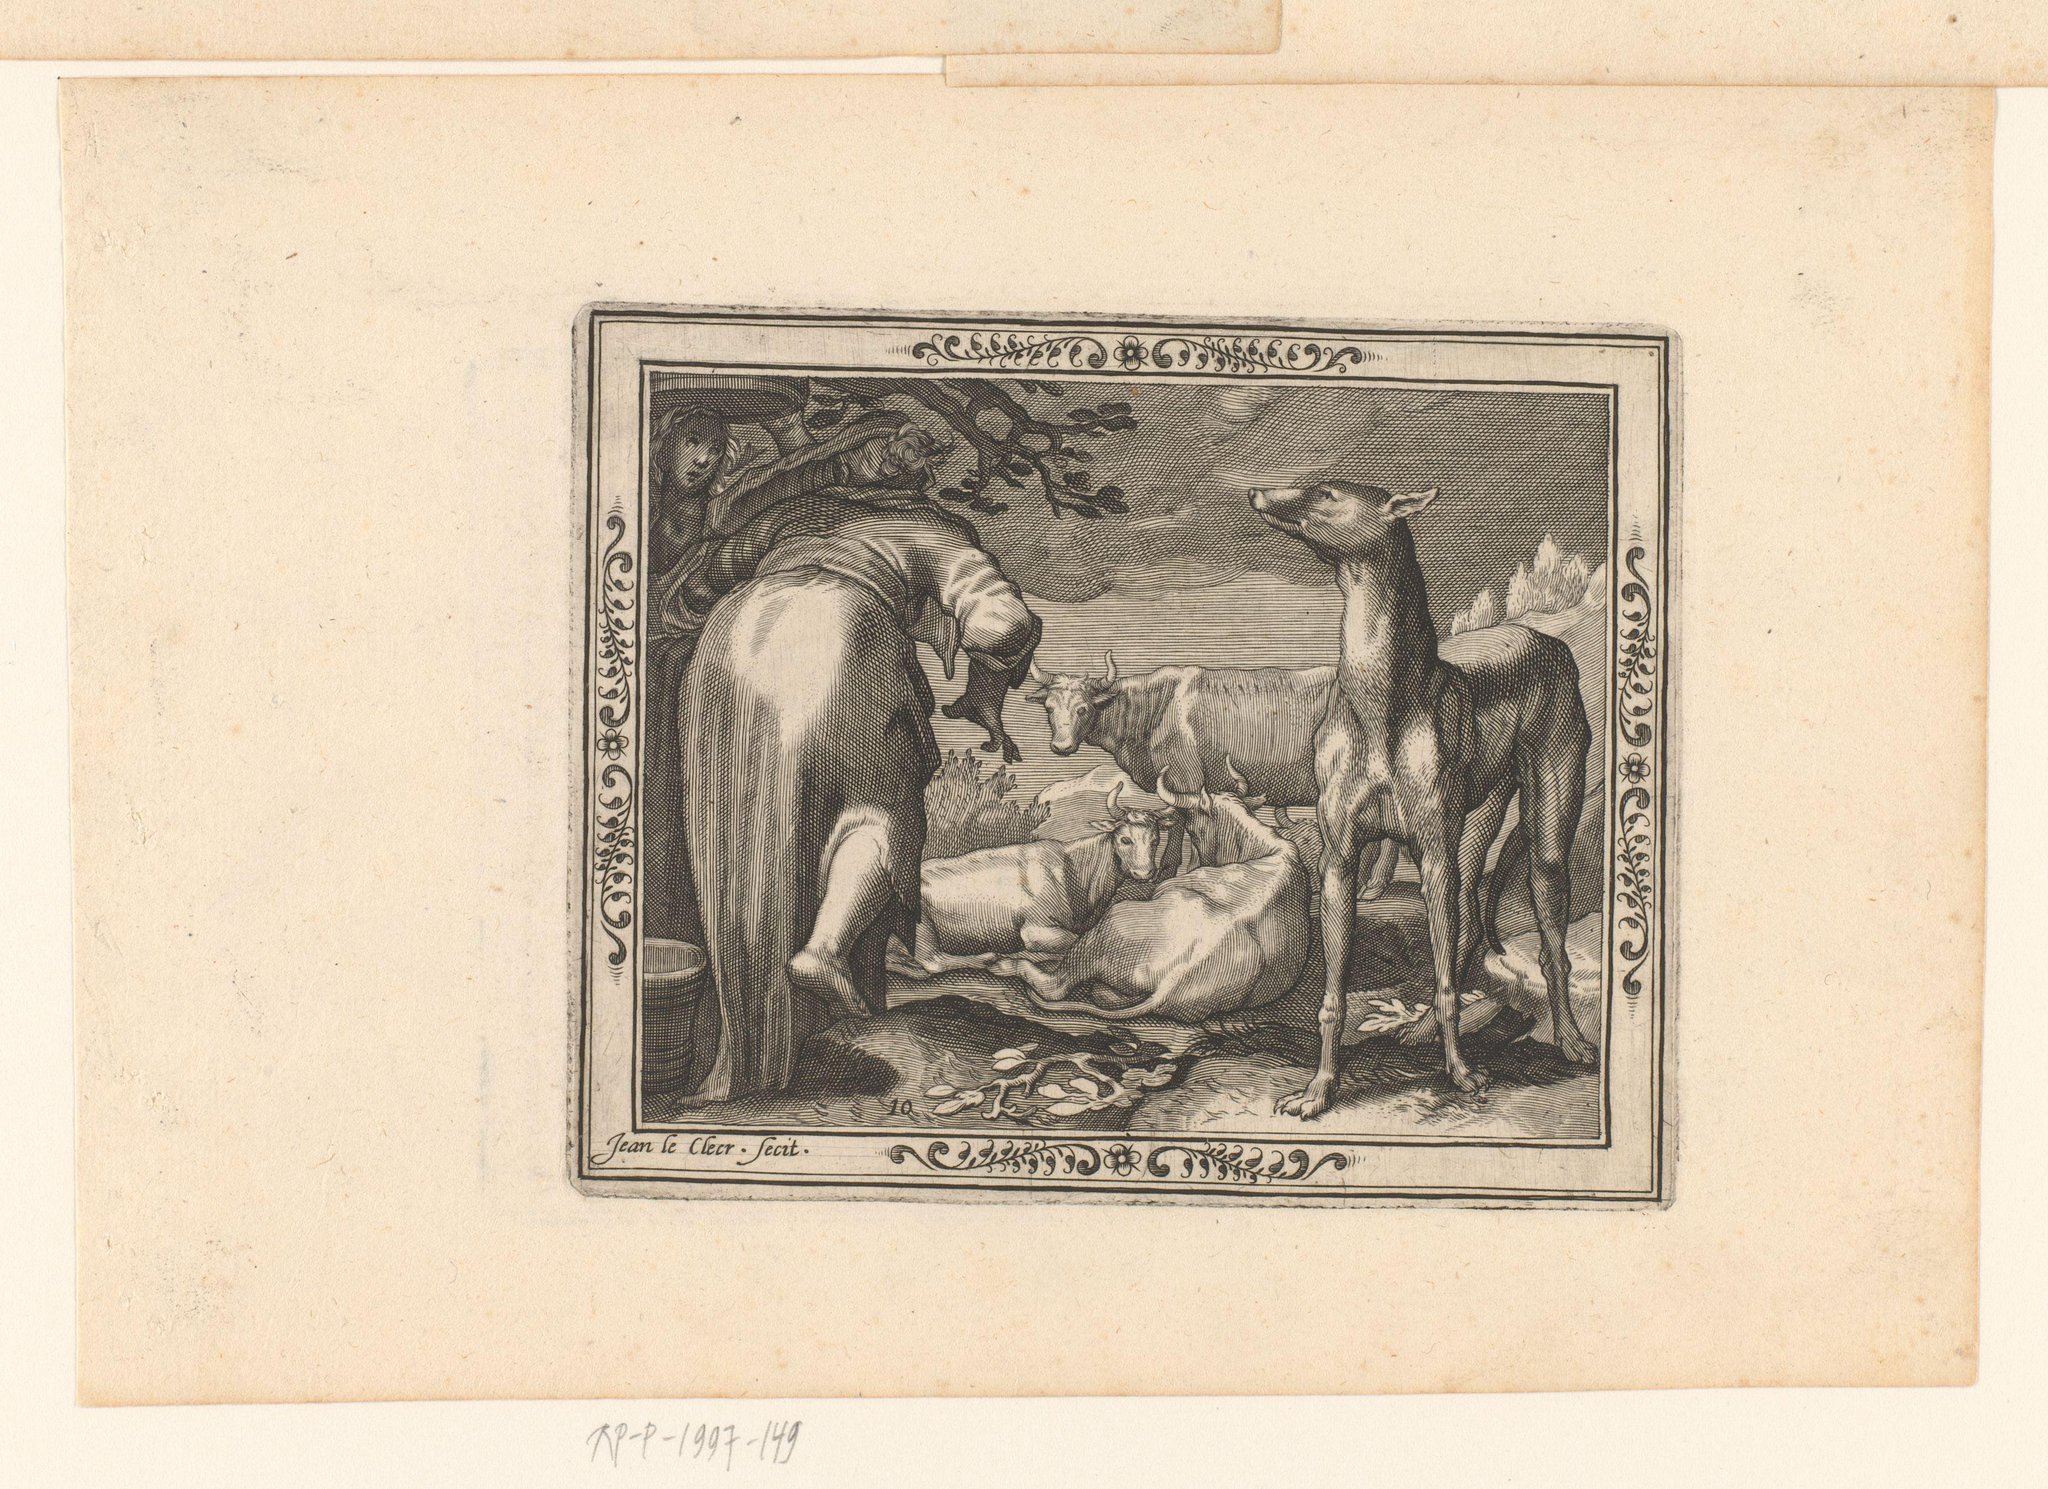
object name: print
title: Hond bij drie koeien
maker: jean leclerc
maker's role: print maker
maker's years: 1587-1633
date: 1597-1633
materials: paper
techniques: engraving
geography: france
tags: cow, dog